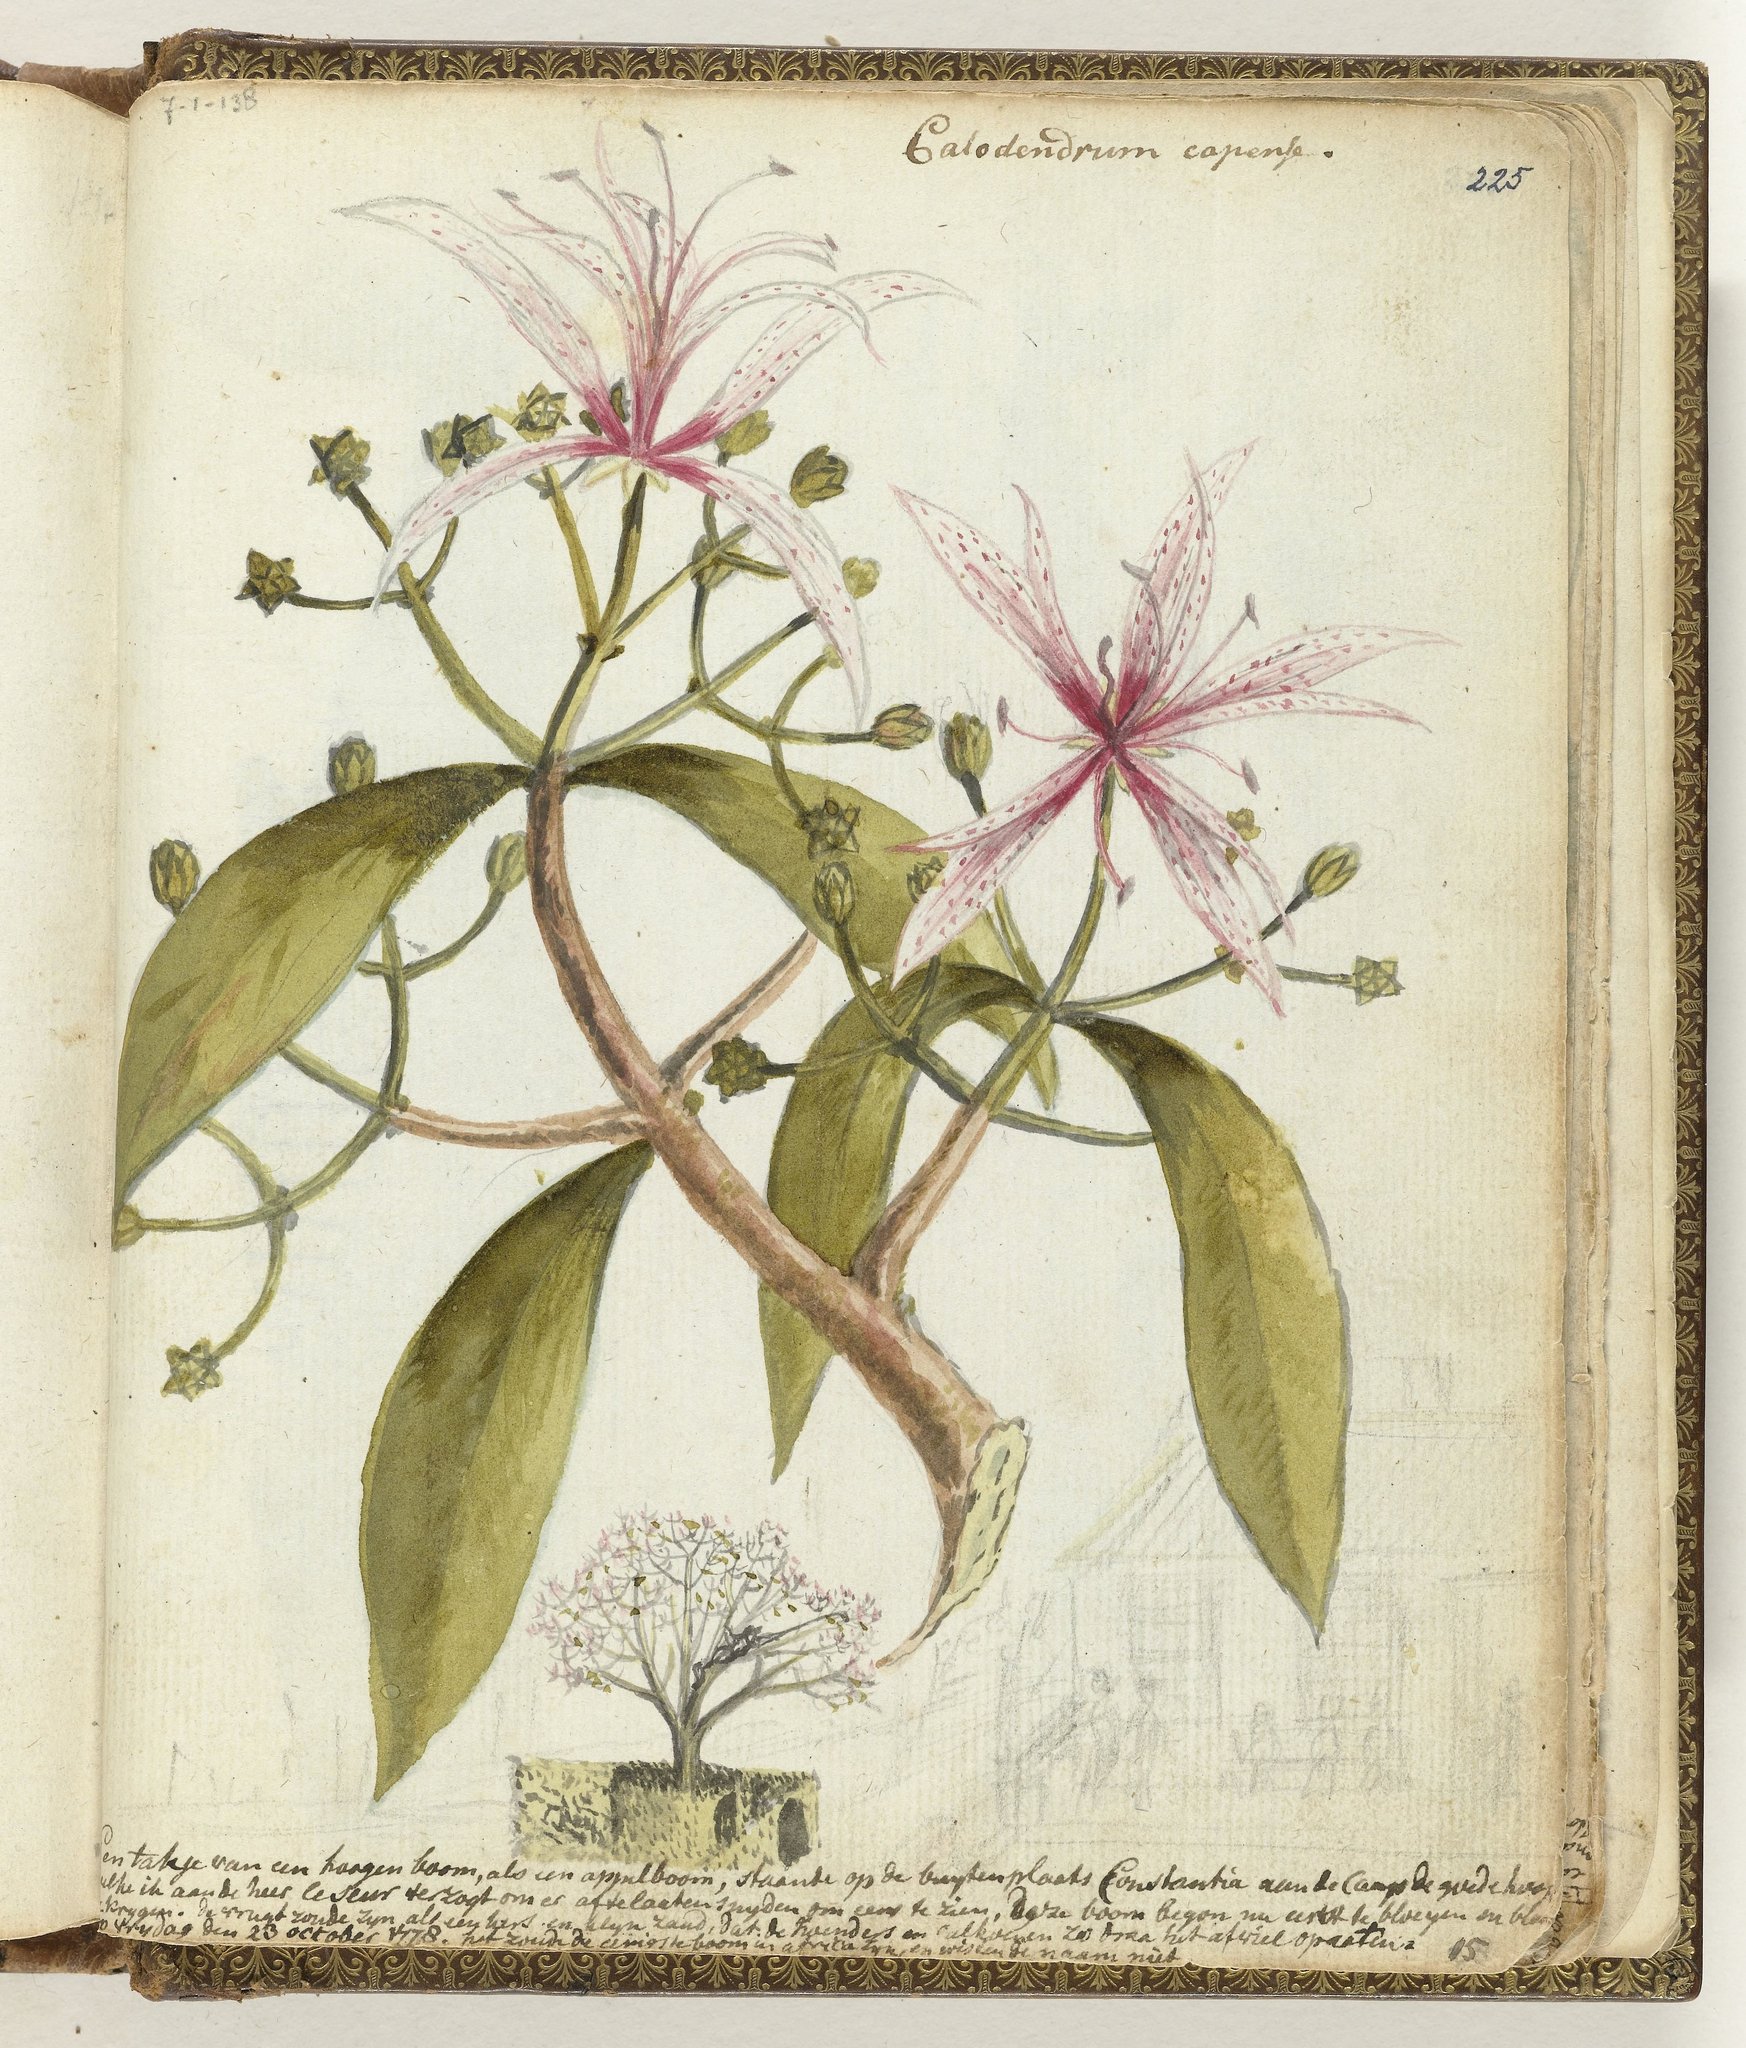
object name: drawing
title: Kaapse hageboom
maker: jan brandes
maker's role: draughtsman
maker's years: 1743-1808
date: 1778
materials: paper, pencil, watercolor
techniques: brush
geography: cape of good hope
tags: flowers, trees, cape of good hope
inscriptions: inscription: ‘Calodendrum capense’, inscription: ‘Een takje van een hoogen boom, als een appelboom, staande op de buytenplaats Constantia aan de Caap de goede hoop welke ik aan de heer Leseur verzogt om er af te laeten snyden om eens te zien. Deze boom begon nu eerst te bloeyen en blad te krygen. De vrugt zoude zyn als een kers en klyn zaad, dat de hoenders en calkoenen zodraa het afviel opaaten. Op vrijdag den 23 october 1778. Het zoude de eenigste boom in Africa zyn en wisten de naam niet.’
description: Kleurtekening van een boomtak met bloesem en een kleine tekening die deels is ingekleurd van de buitenplaats waar de tekenaar de tak vandaan heeft. Onderdeel uit het schetsboek van Jan Brandes, dl. 1 (1808), p. 225.